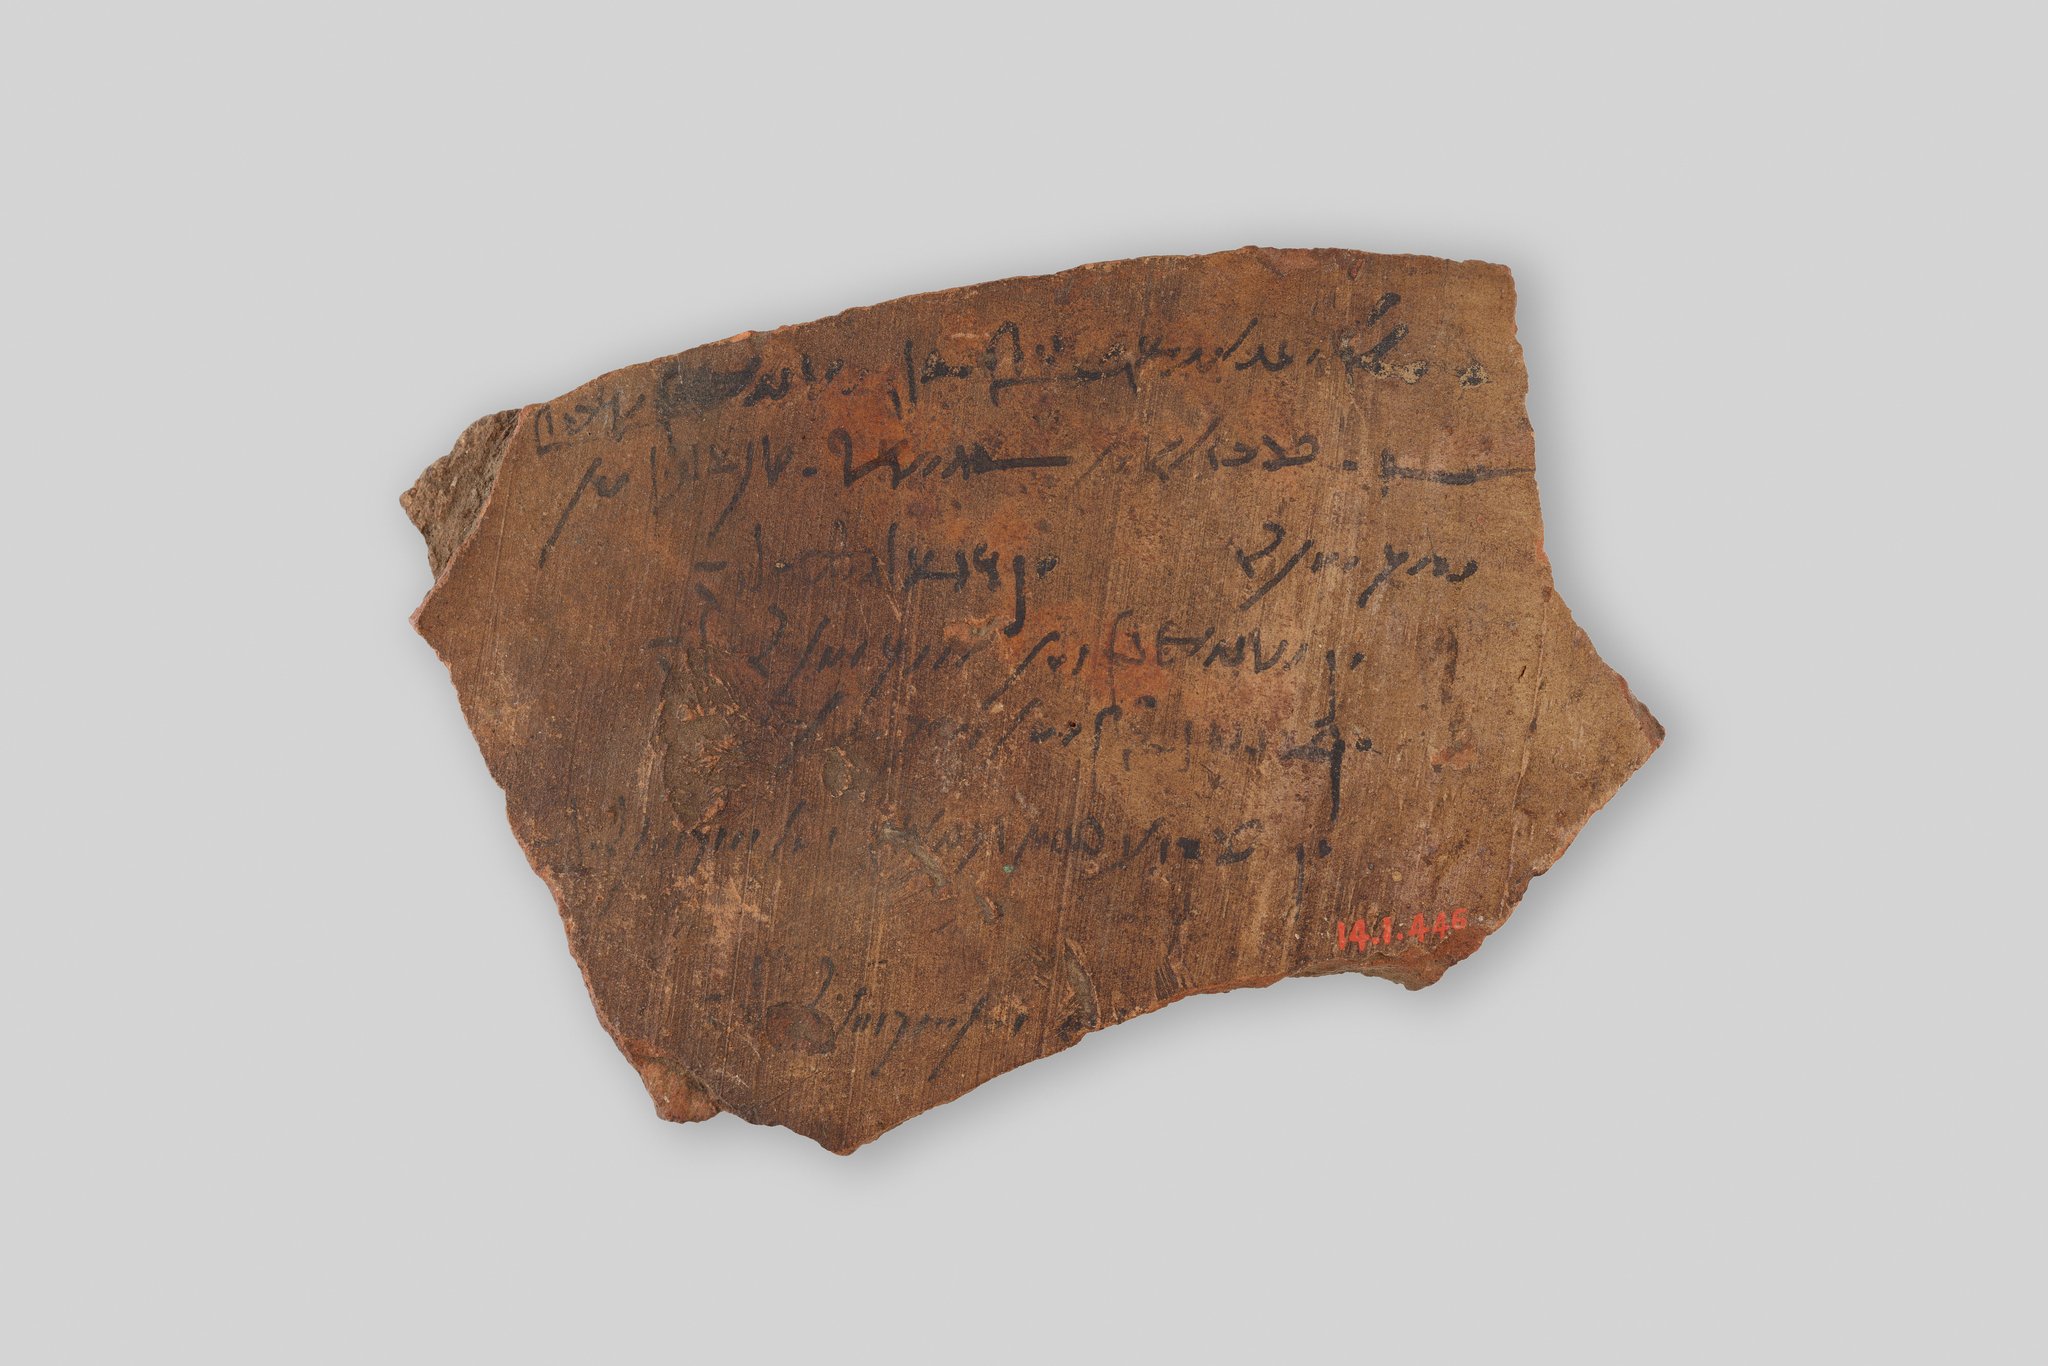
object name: ostracon, demotic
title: Ostracon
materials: ink, pottery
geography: egypt